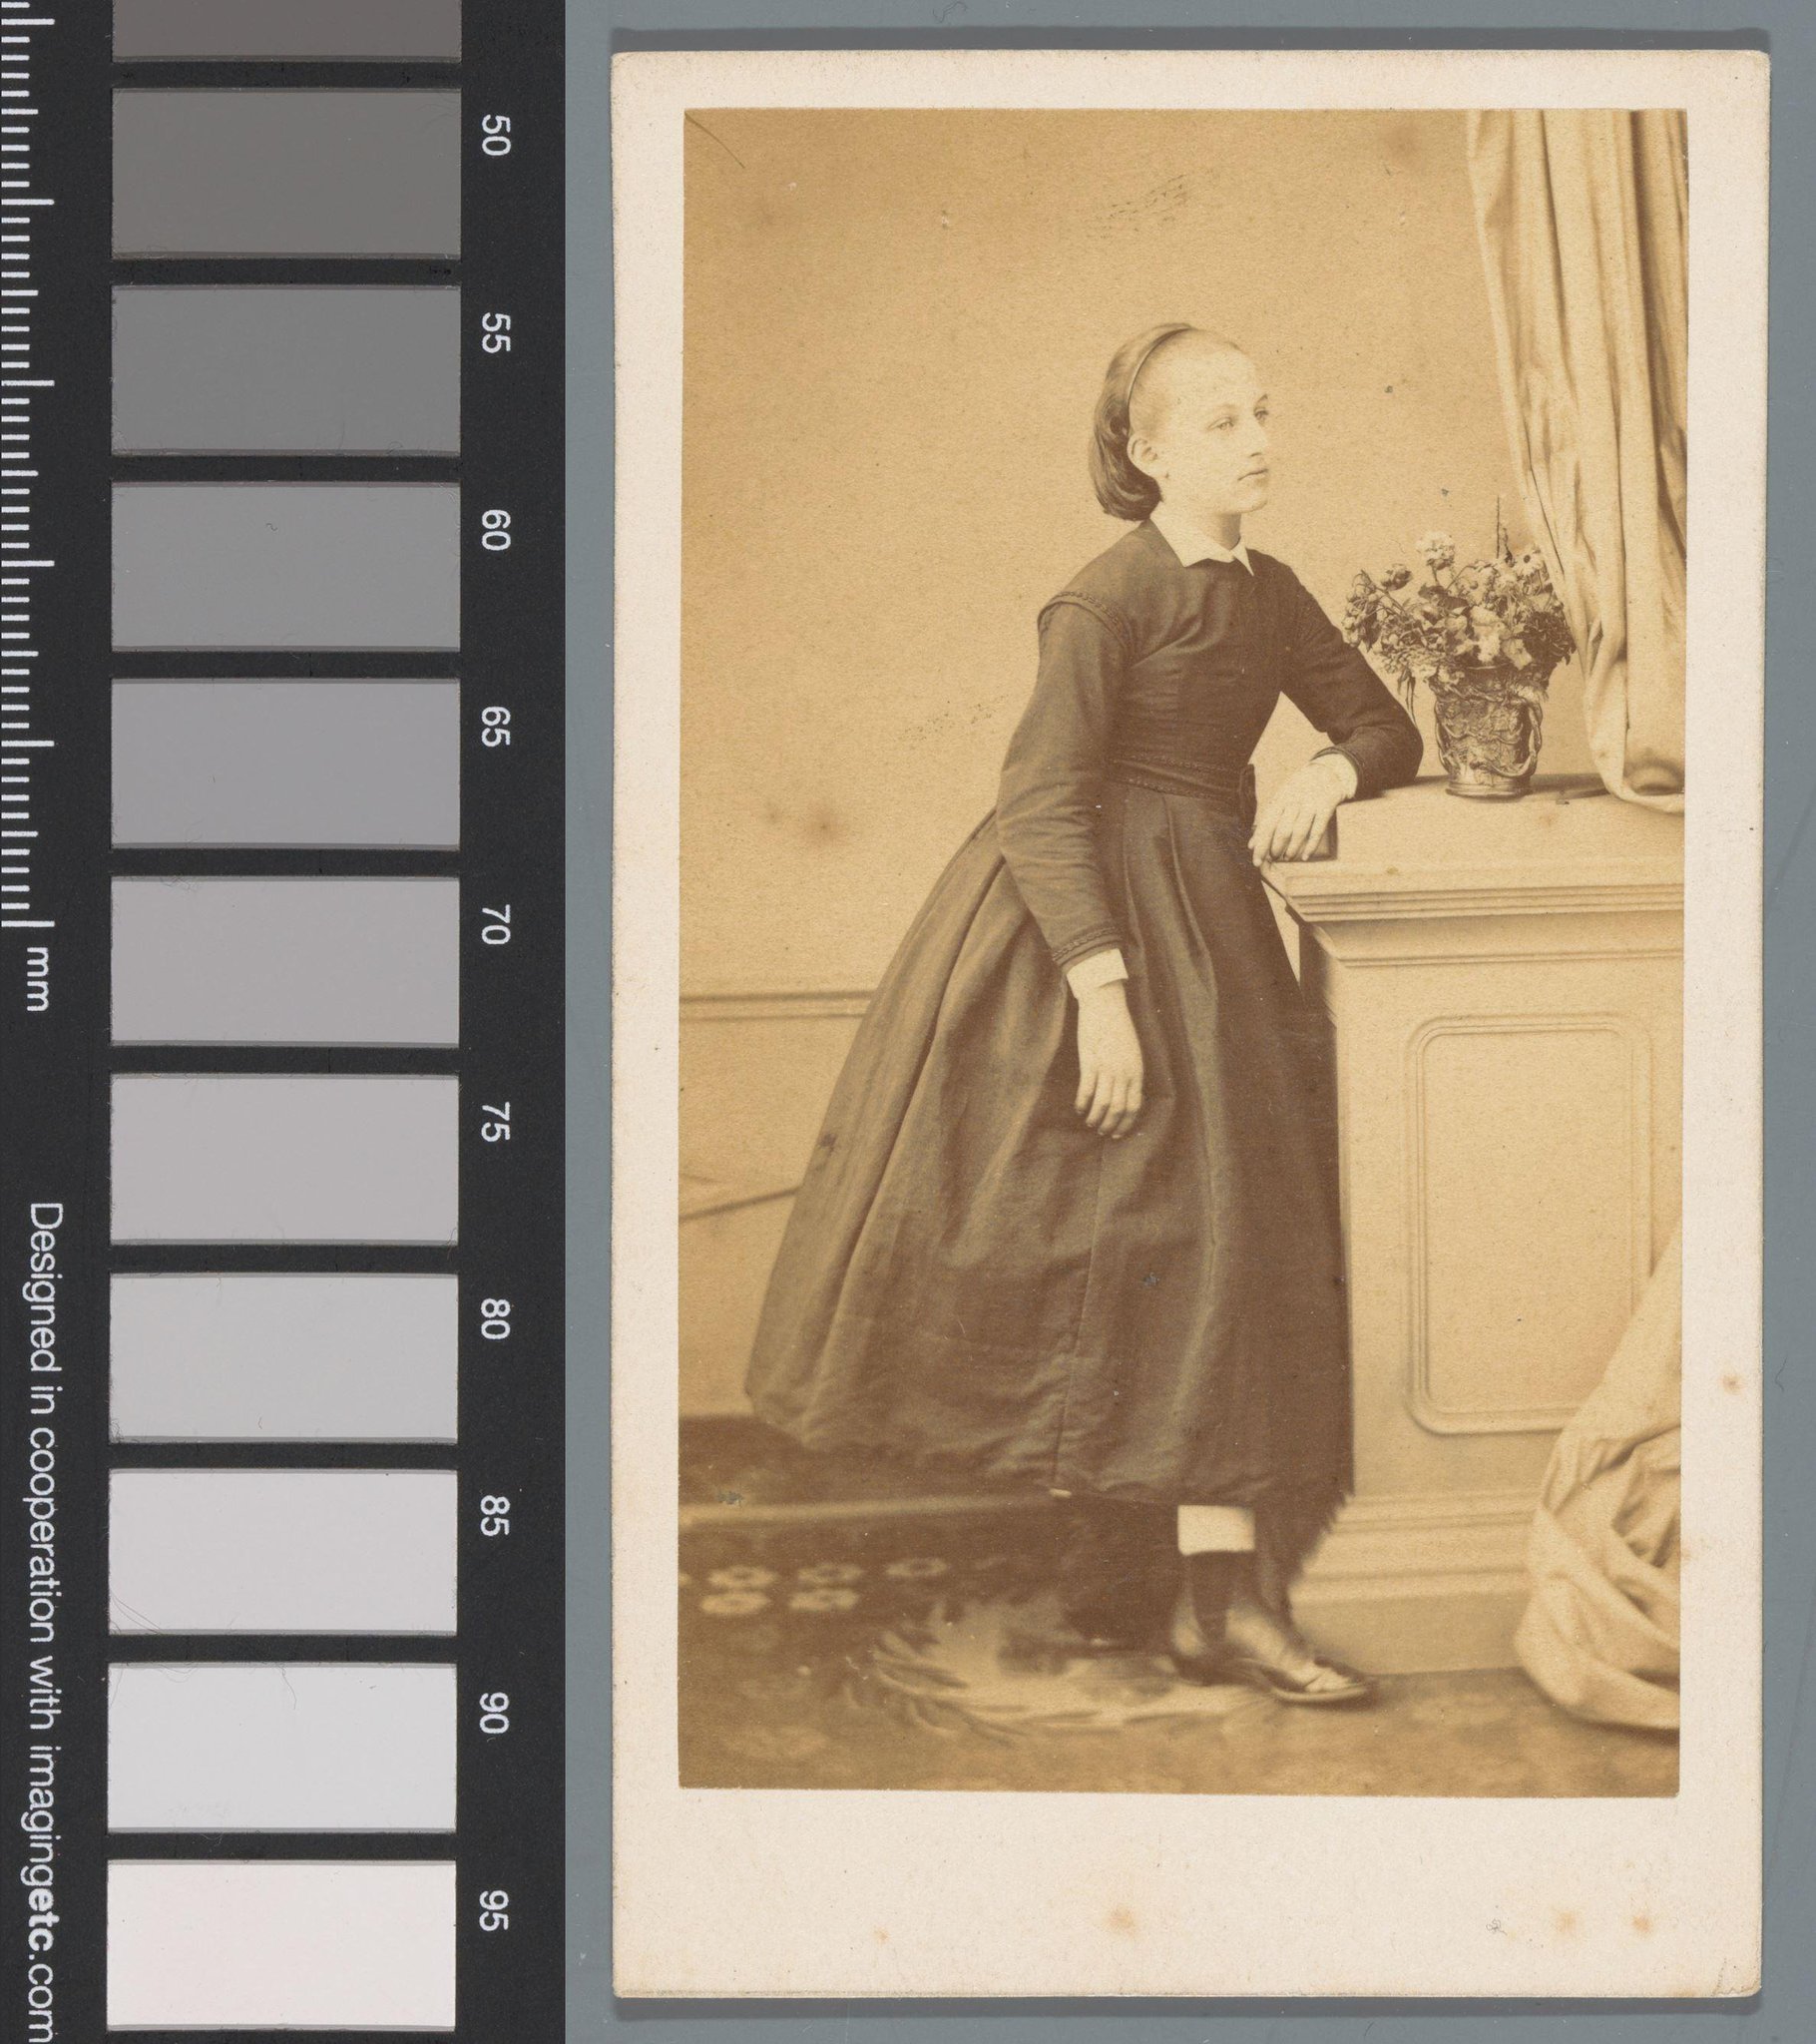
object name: photograph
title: Portret van een onbekende jonge vrouw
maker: v. vagneur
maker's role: publisher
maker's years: 1822-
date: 1855-1885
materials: cardboard, paper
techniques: albumen print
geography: paris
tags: adolescent, young woman, maiden, anonymous historical person portrayed, paris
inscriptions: inscription: ‘Photographie/ Vve. Vagneur/ Rue Drouot 19./ Paris’